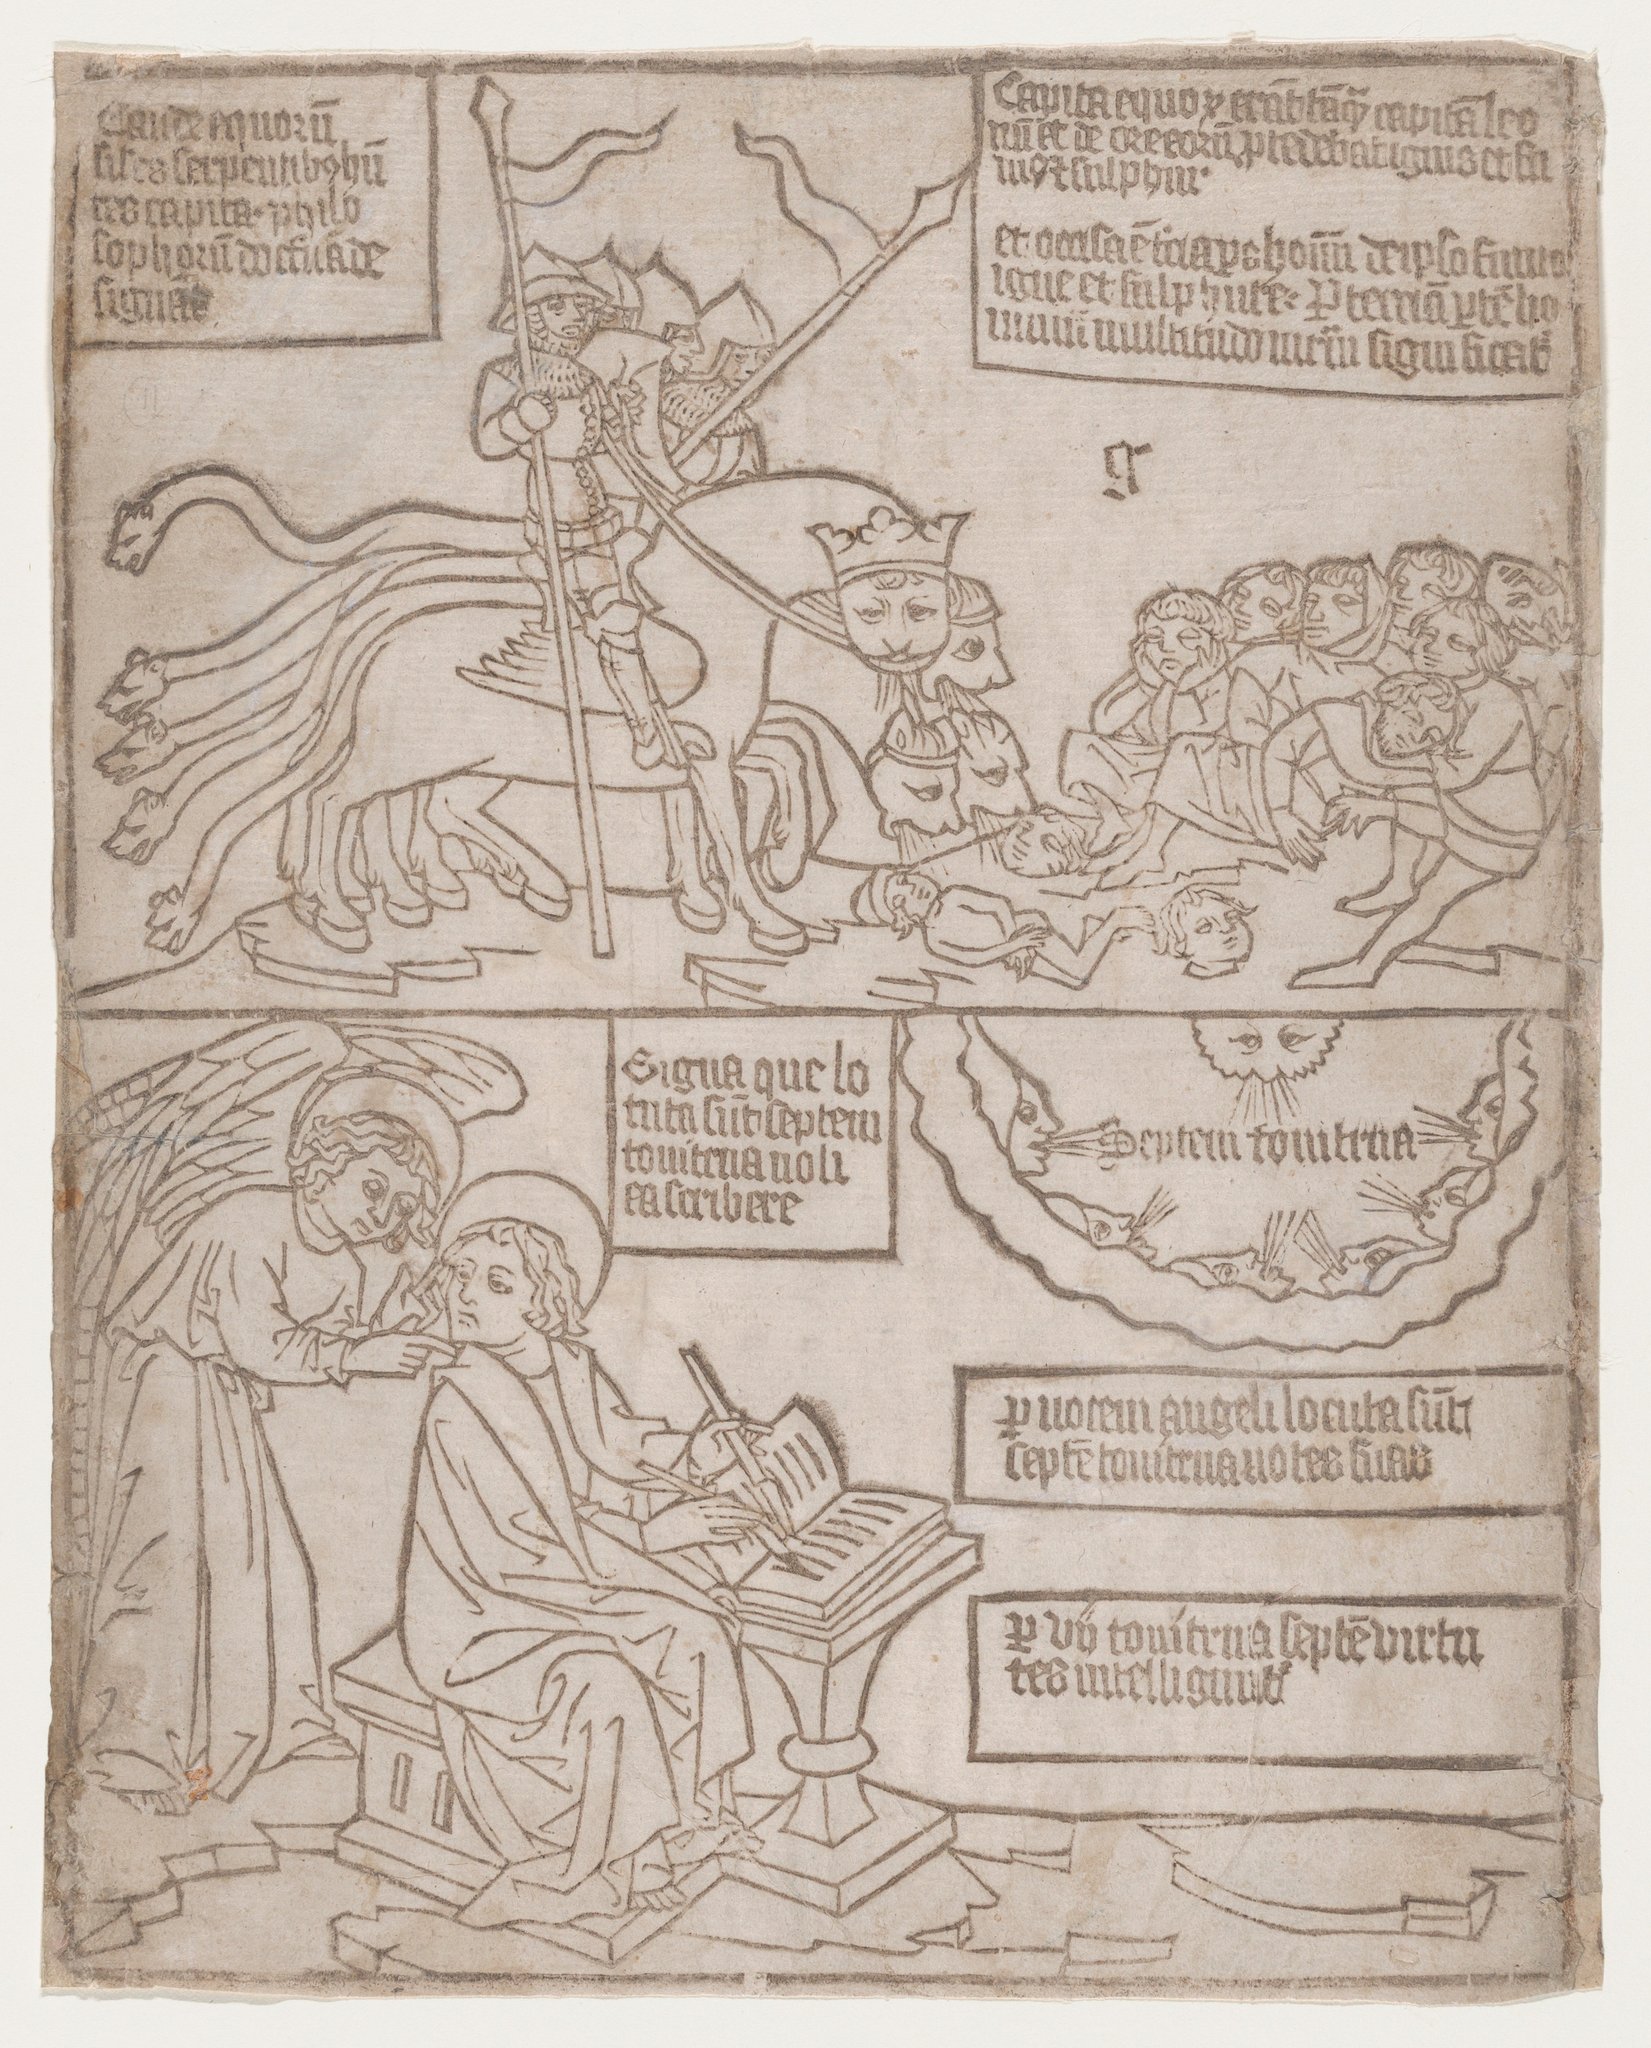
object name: print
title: The Angels of the Euphrates Killing Mankind; and The Angel Preventing Saint John from Recording the Words of the Seven Thunders, from an "Apocalypse" blockbook, second edition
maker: anonymous, netherlandish, 15th century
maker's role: artist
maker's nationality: netherlandish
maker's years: 1400-1500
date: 1440-1450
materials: ink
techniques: printing, woodcut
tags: soldiers,horses,angels,saint john the evangelist